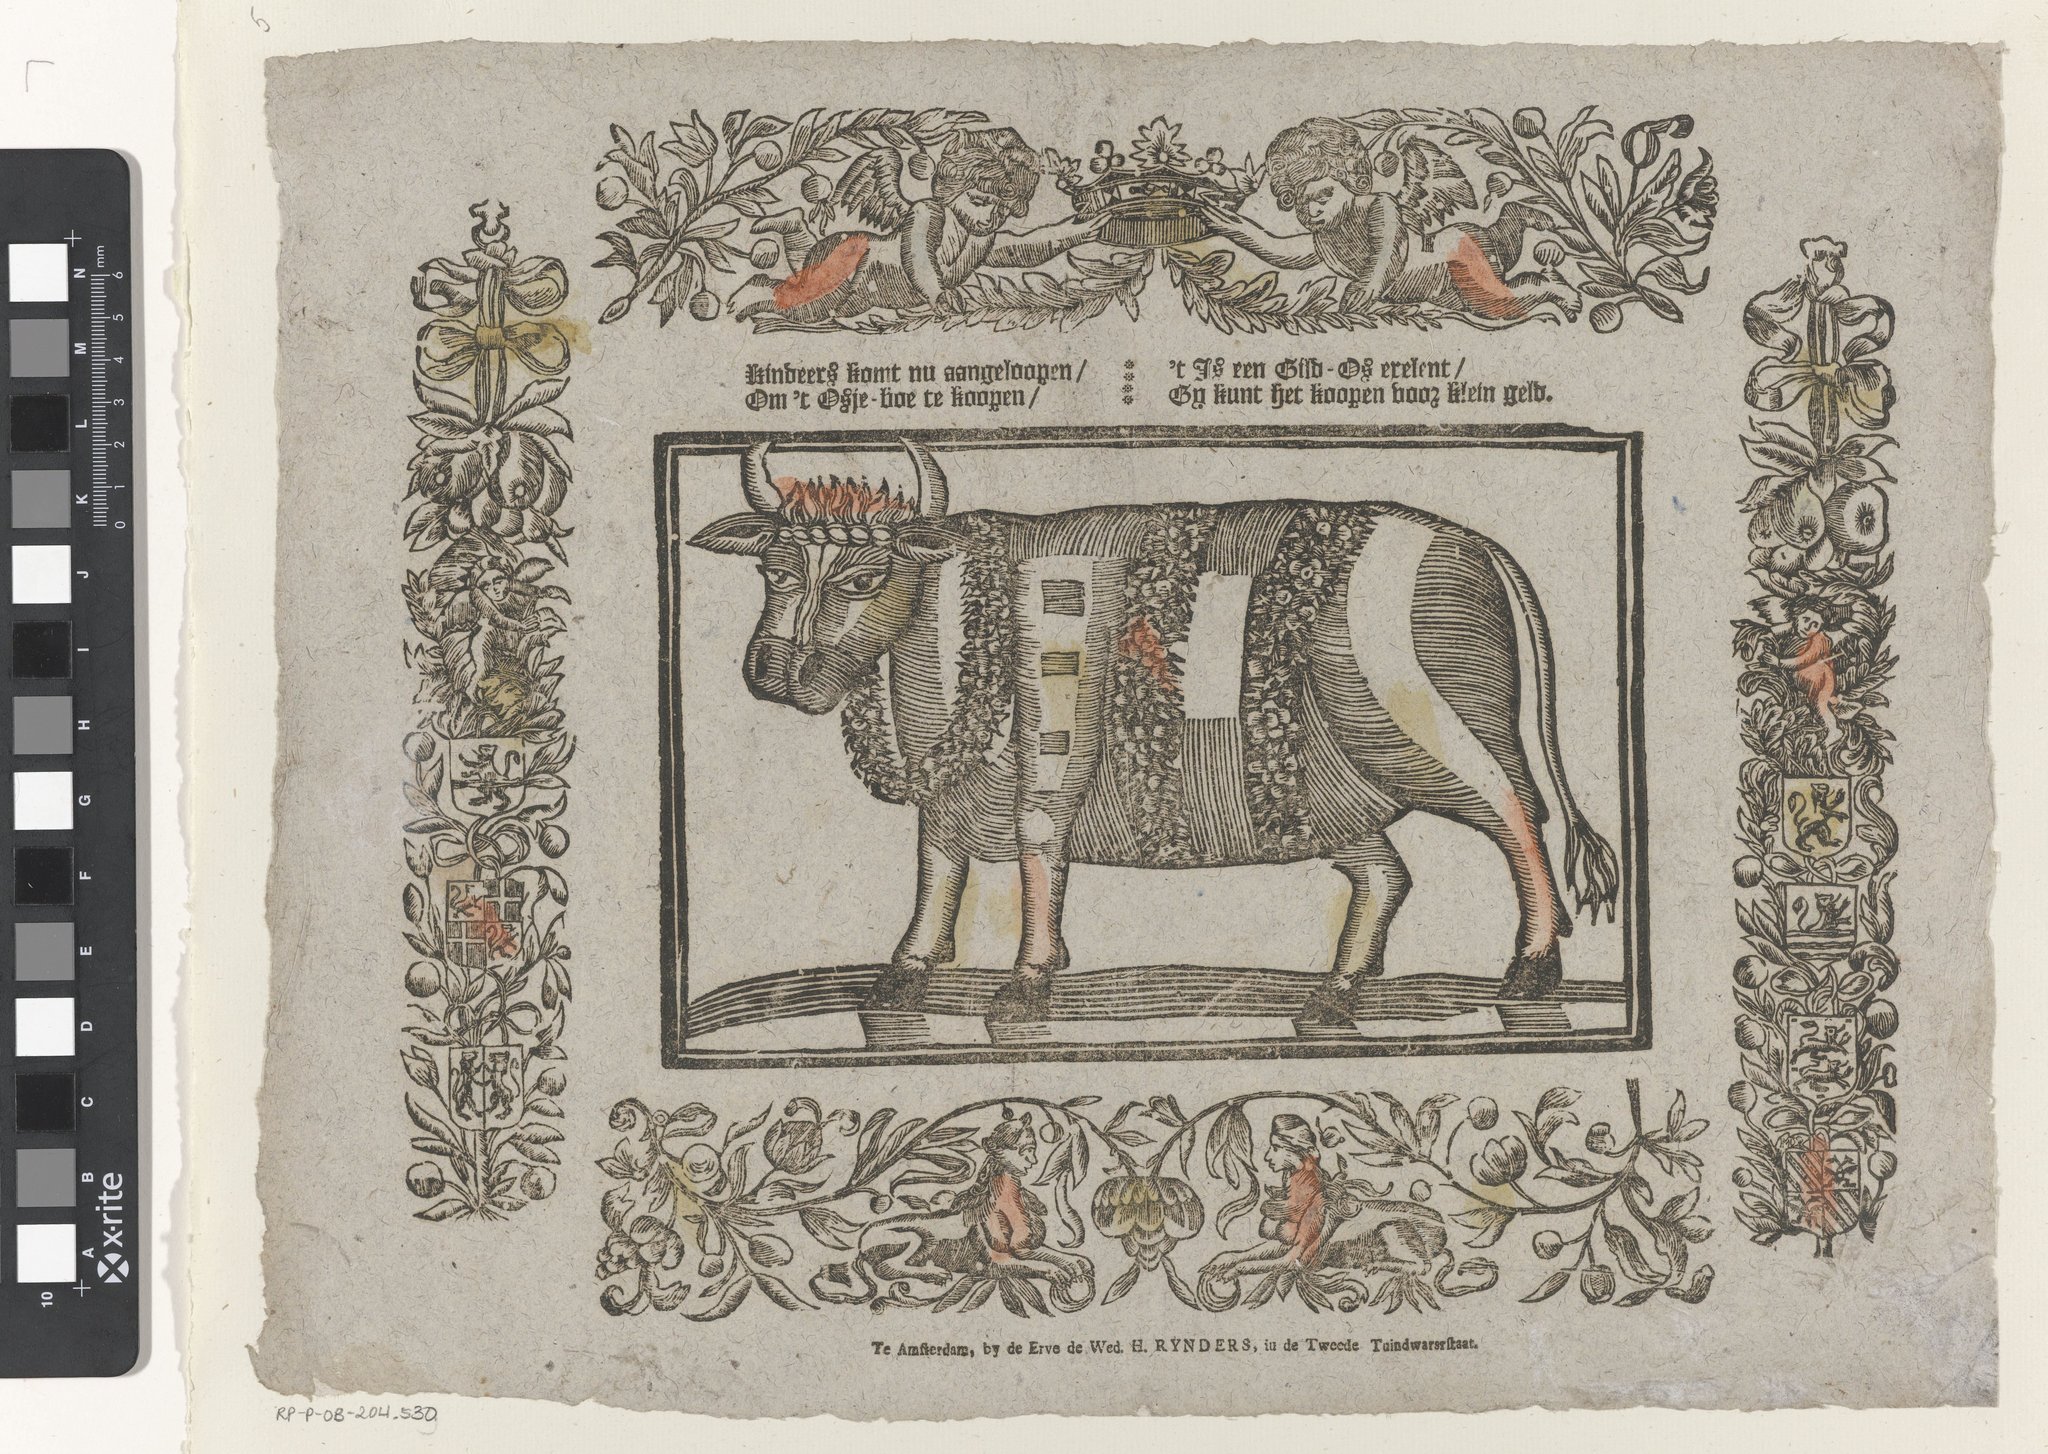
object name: popular print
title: Kinders komt nu aangeloopen / Om 't osje boe te koopen / 't is een gild-os exelent / Gy kunt het koopen voor klein geld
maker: Anonymous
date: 1781-1831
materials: paper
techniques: colour, letterpress printing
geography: netherlands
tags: floral interlace ~ ornament, prize-ox, ox, cupids: 'amores', 'amoretti', 'putti'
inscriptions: collector's mark: Lugt 2760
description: Blad met een grote voorstelling van een gilde-os (ook kermisos of prijsos genoemd), versierd met bloemenkransen. De voorstelling is gevat in een sierlijst met ranken, sfinxen, wapenschilden, putti en bloemen.